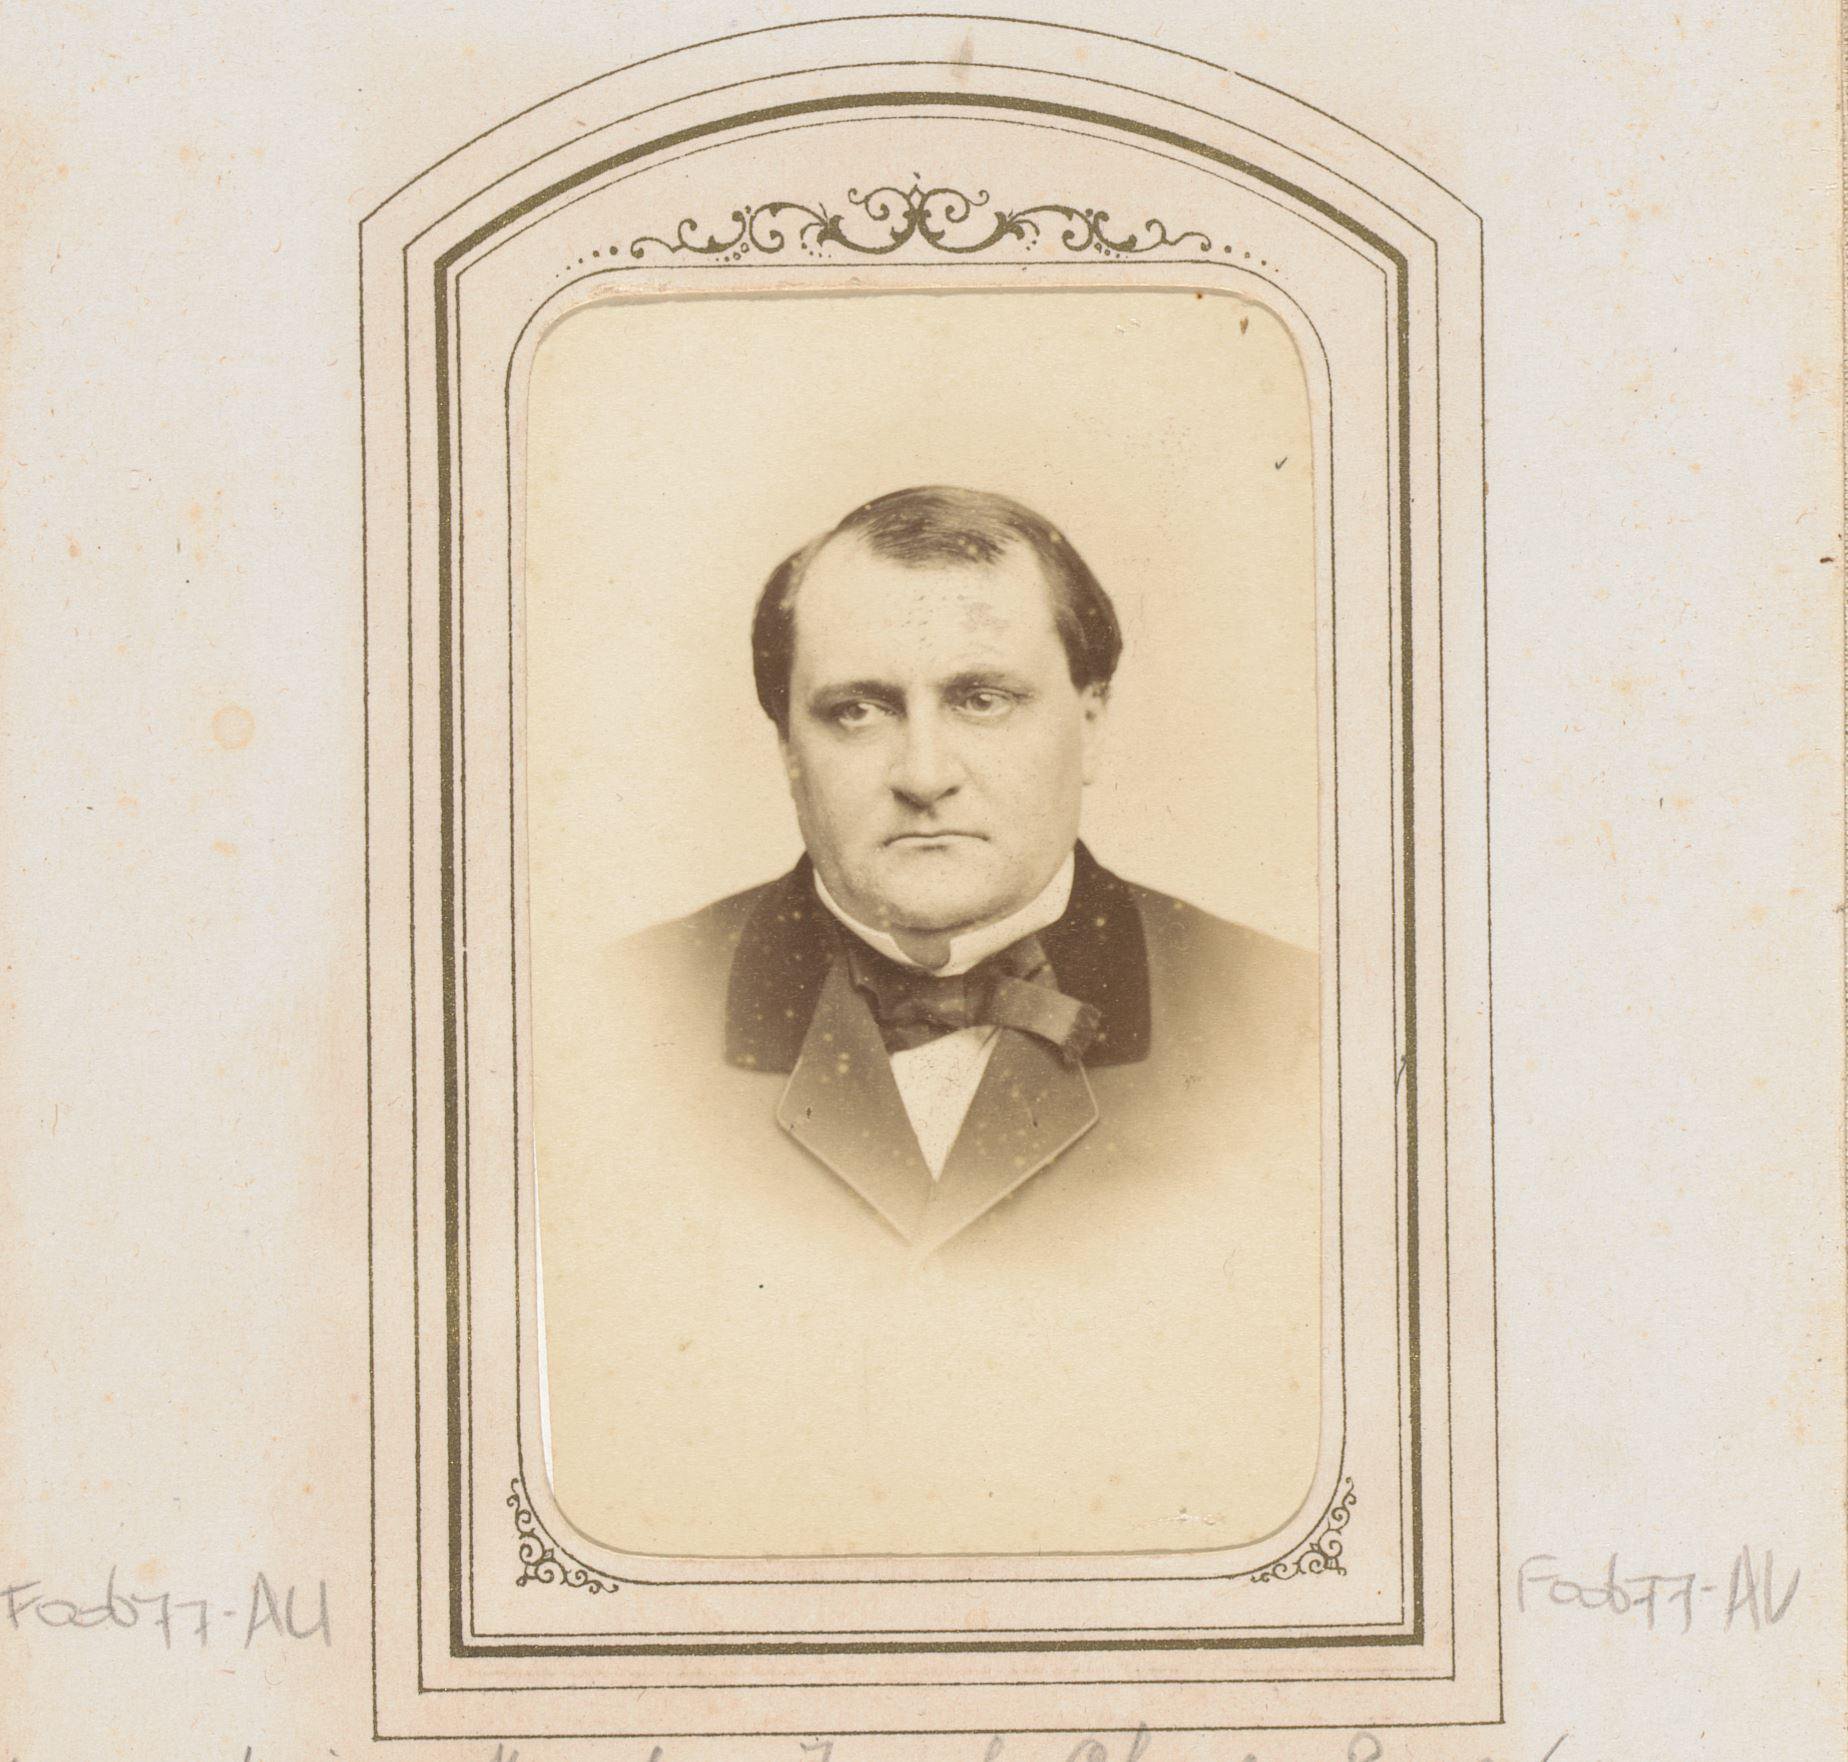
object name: carte de visite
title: Portret van Napoleon Jozef Karel Paul Bonaparte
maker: charles reutlinger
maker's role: publisher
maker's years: 1816-1880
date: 1850-1870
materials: cardboard, photographic support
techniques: albumen print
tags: historical persons, family of the sovereign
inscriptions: annotation: ‘prins Napoleon Joseph Charles Paul (zoon/ Jérome Bonaparte, koning Westfalen, broer/ Napoleon I) 1822-1891’, inscription: ‘CH. REUTLINGER,/ PHOTOGRAPHE/ 21, Boulevart Montmartre, 21/ 112, Rue Richelieu, 112/ PARIS’, annotation: ‘Prinz Napoleon’